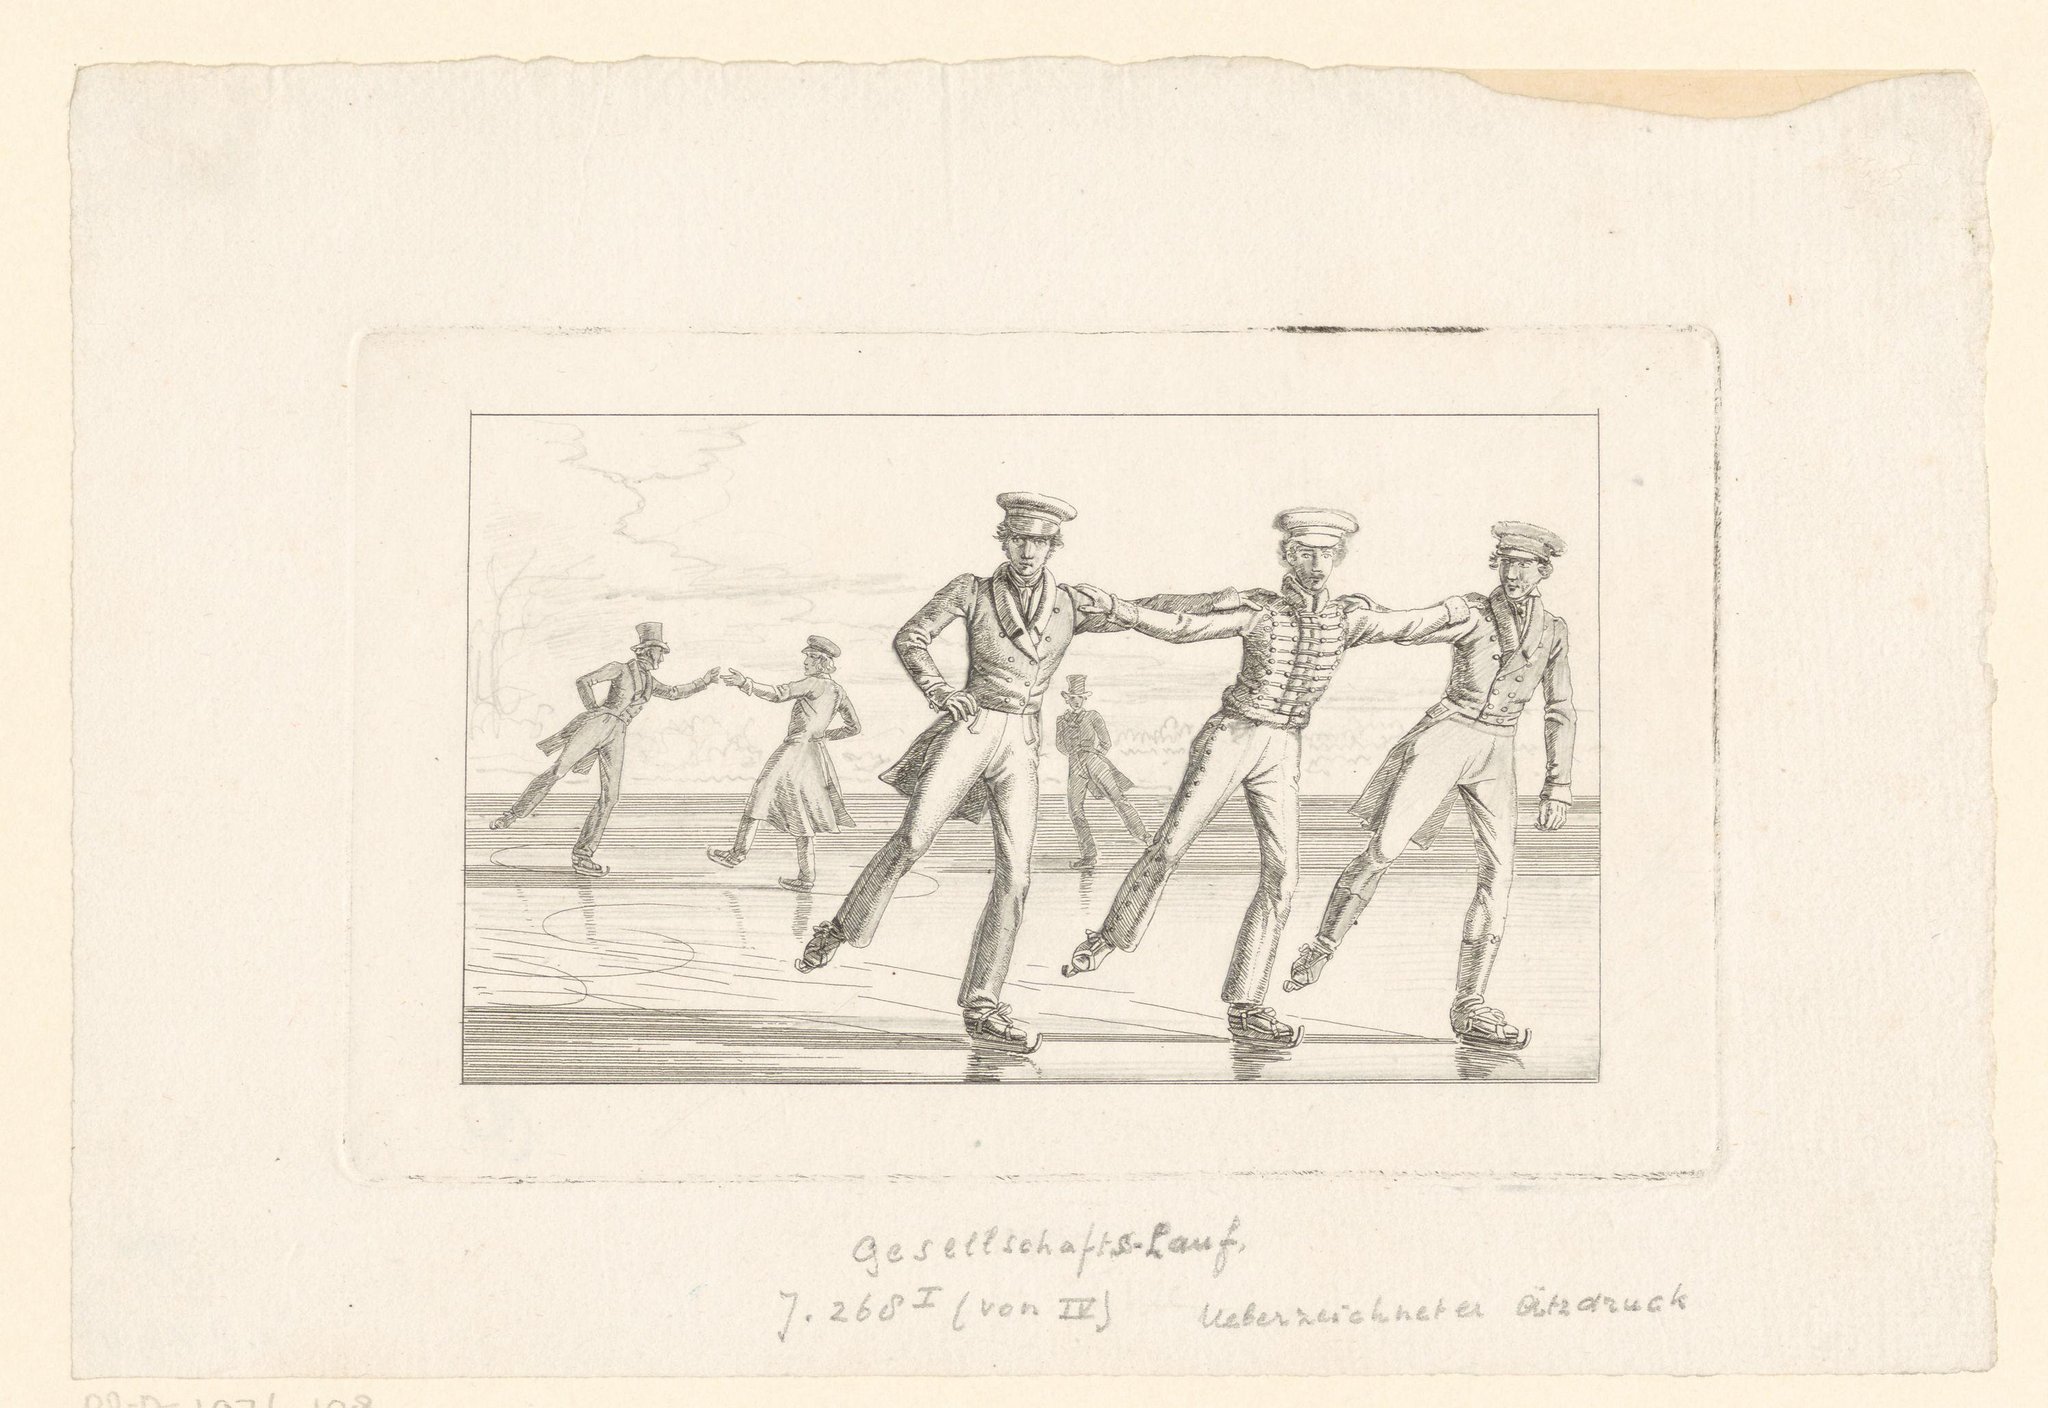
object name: print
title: Vijf mannen schaatsen met elkaar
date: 1825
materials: paper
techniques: etching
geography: nuremberg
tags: skates (winter sports)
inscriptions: collector's mark: Lugt 4731, collector's mark: Lugt 2228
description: Prent is waarschijnlijk gebruikt in: Zindel, Christian Siegmund, Klopstock, Friedrich Gottlieb, Klein, Johann Adam. Der Eislauf oder das Schrittschuhfahren, ein Taschenbuch für Jung und Alt. Mit Gedichten von Klopstock, Goethe, Herder, Cramer, Krummacher etc: und Kupfern von J.A. Klein. Neurenberg: Friedrich Campe, 1825. In de catalogus door C. Jahn. Das Werk von Johann Adam Klein : Maler und Kupferätzer zu München [...]. München: Montmorillonschen Kunsthandlung, 1863 is deze prent getiteld: Geschellschafts-Lauf.